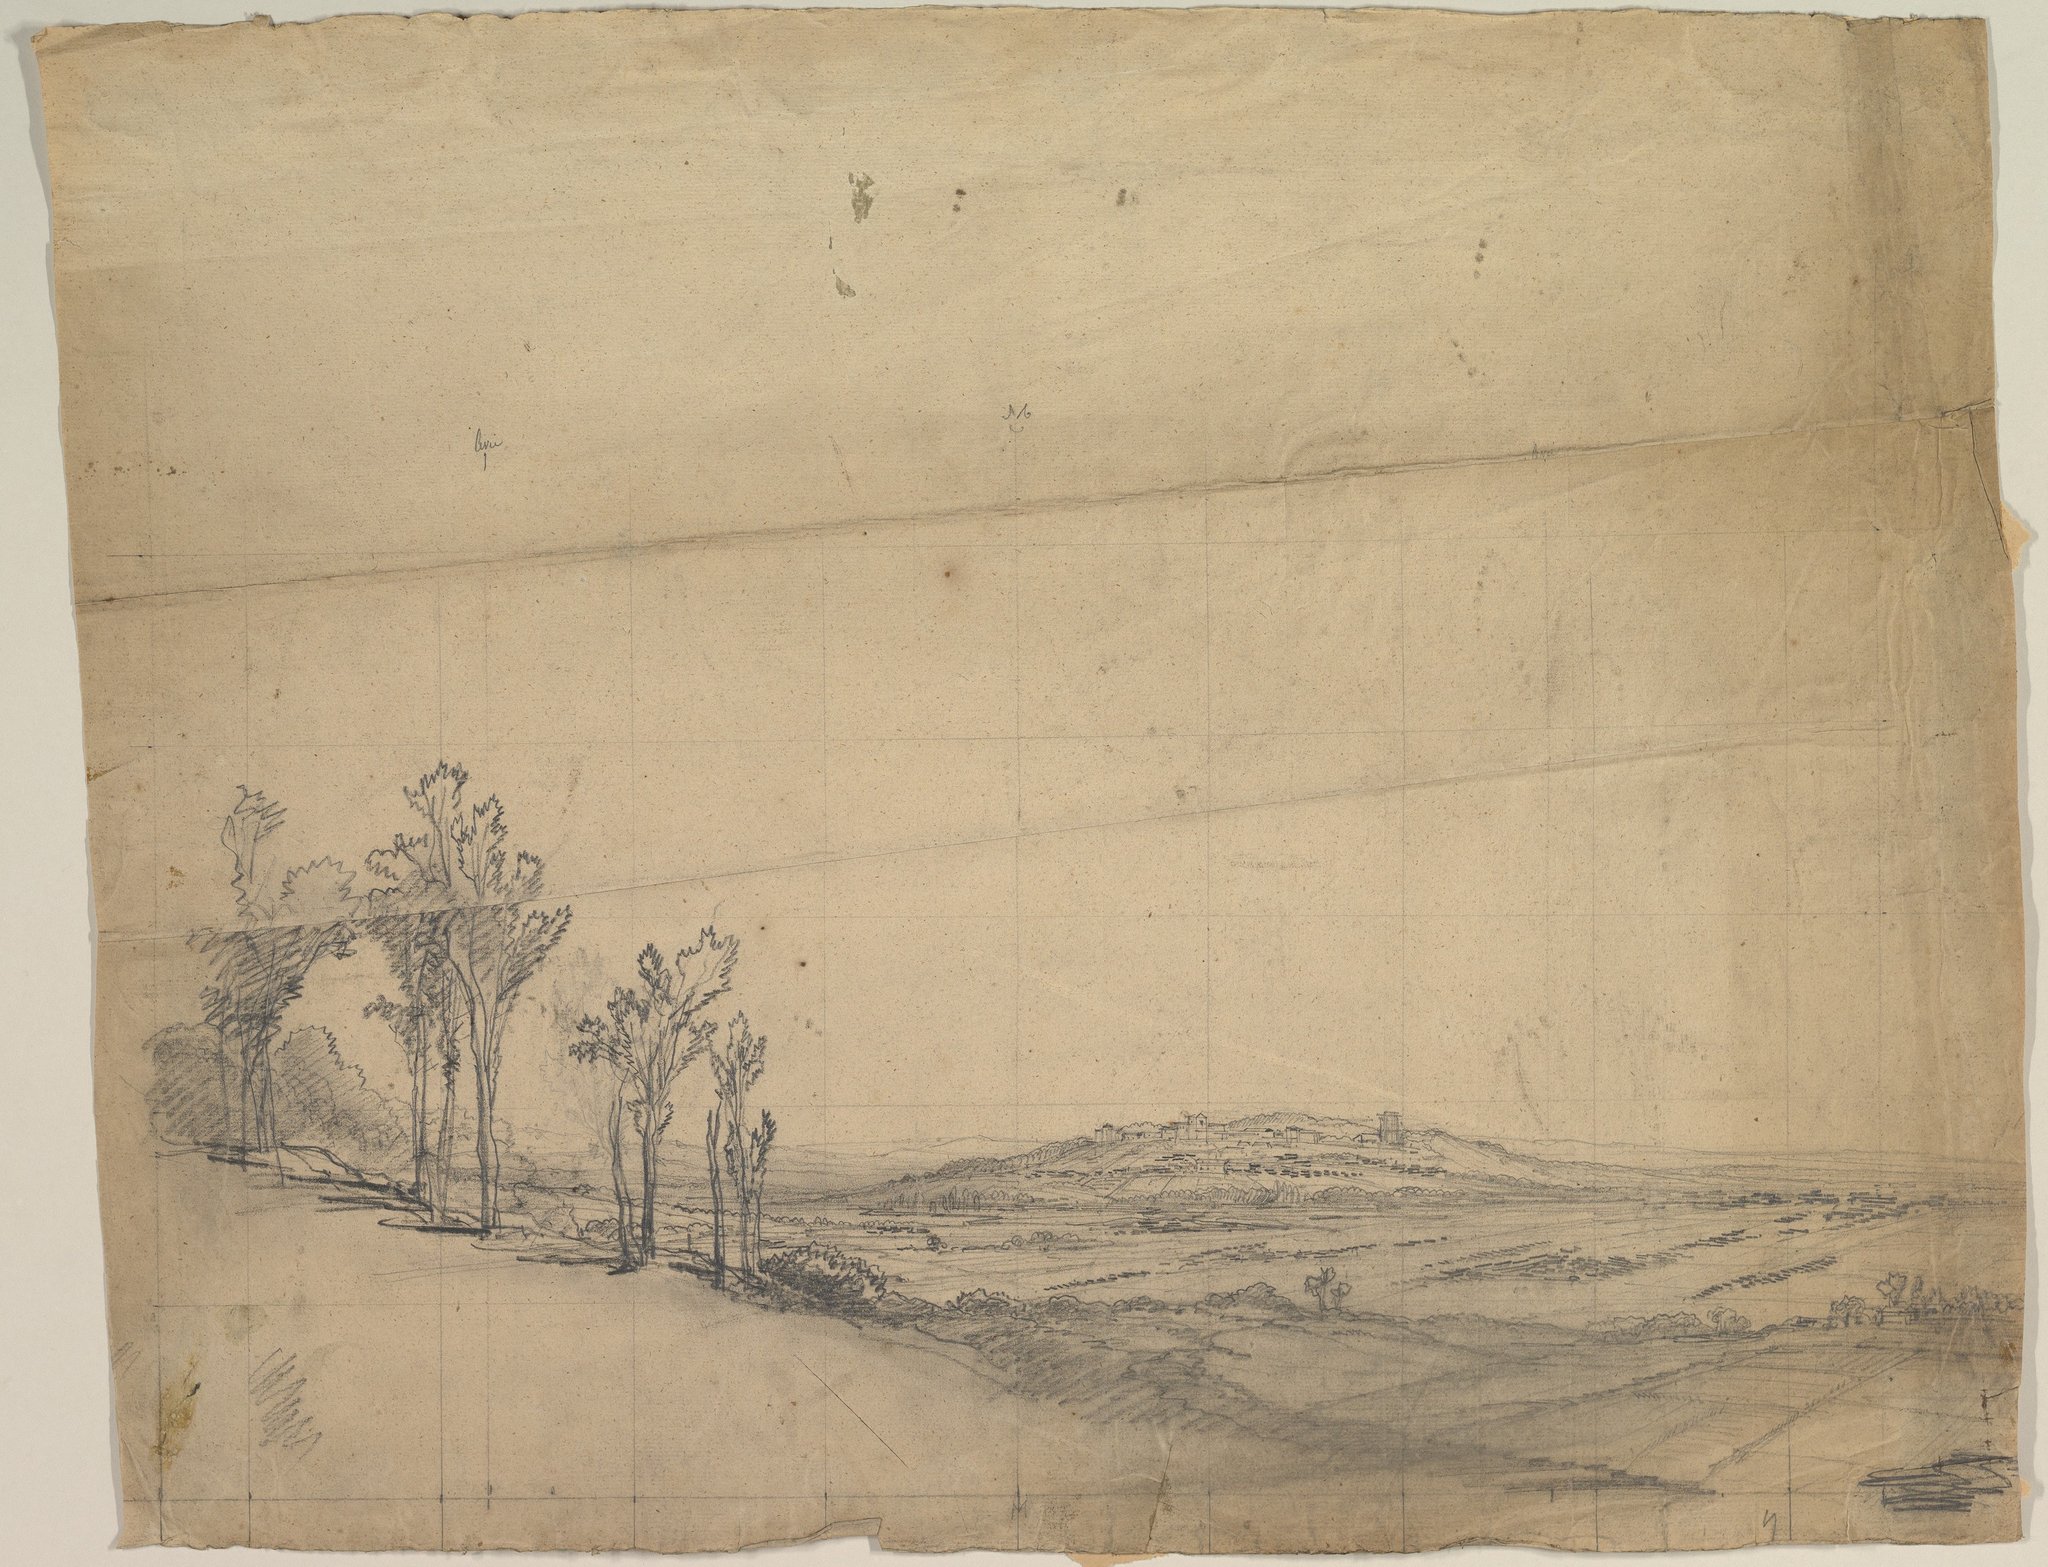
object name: drawing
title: Design for a Stage Set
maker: eugène cicéri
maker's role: artist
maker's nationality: french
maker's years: 1813-1890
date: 1828-1890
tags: landscapes,stage design